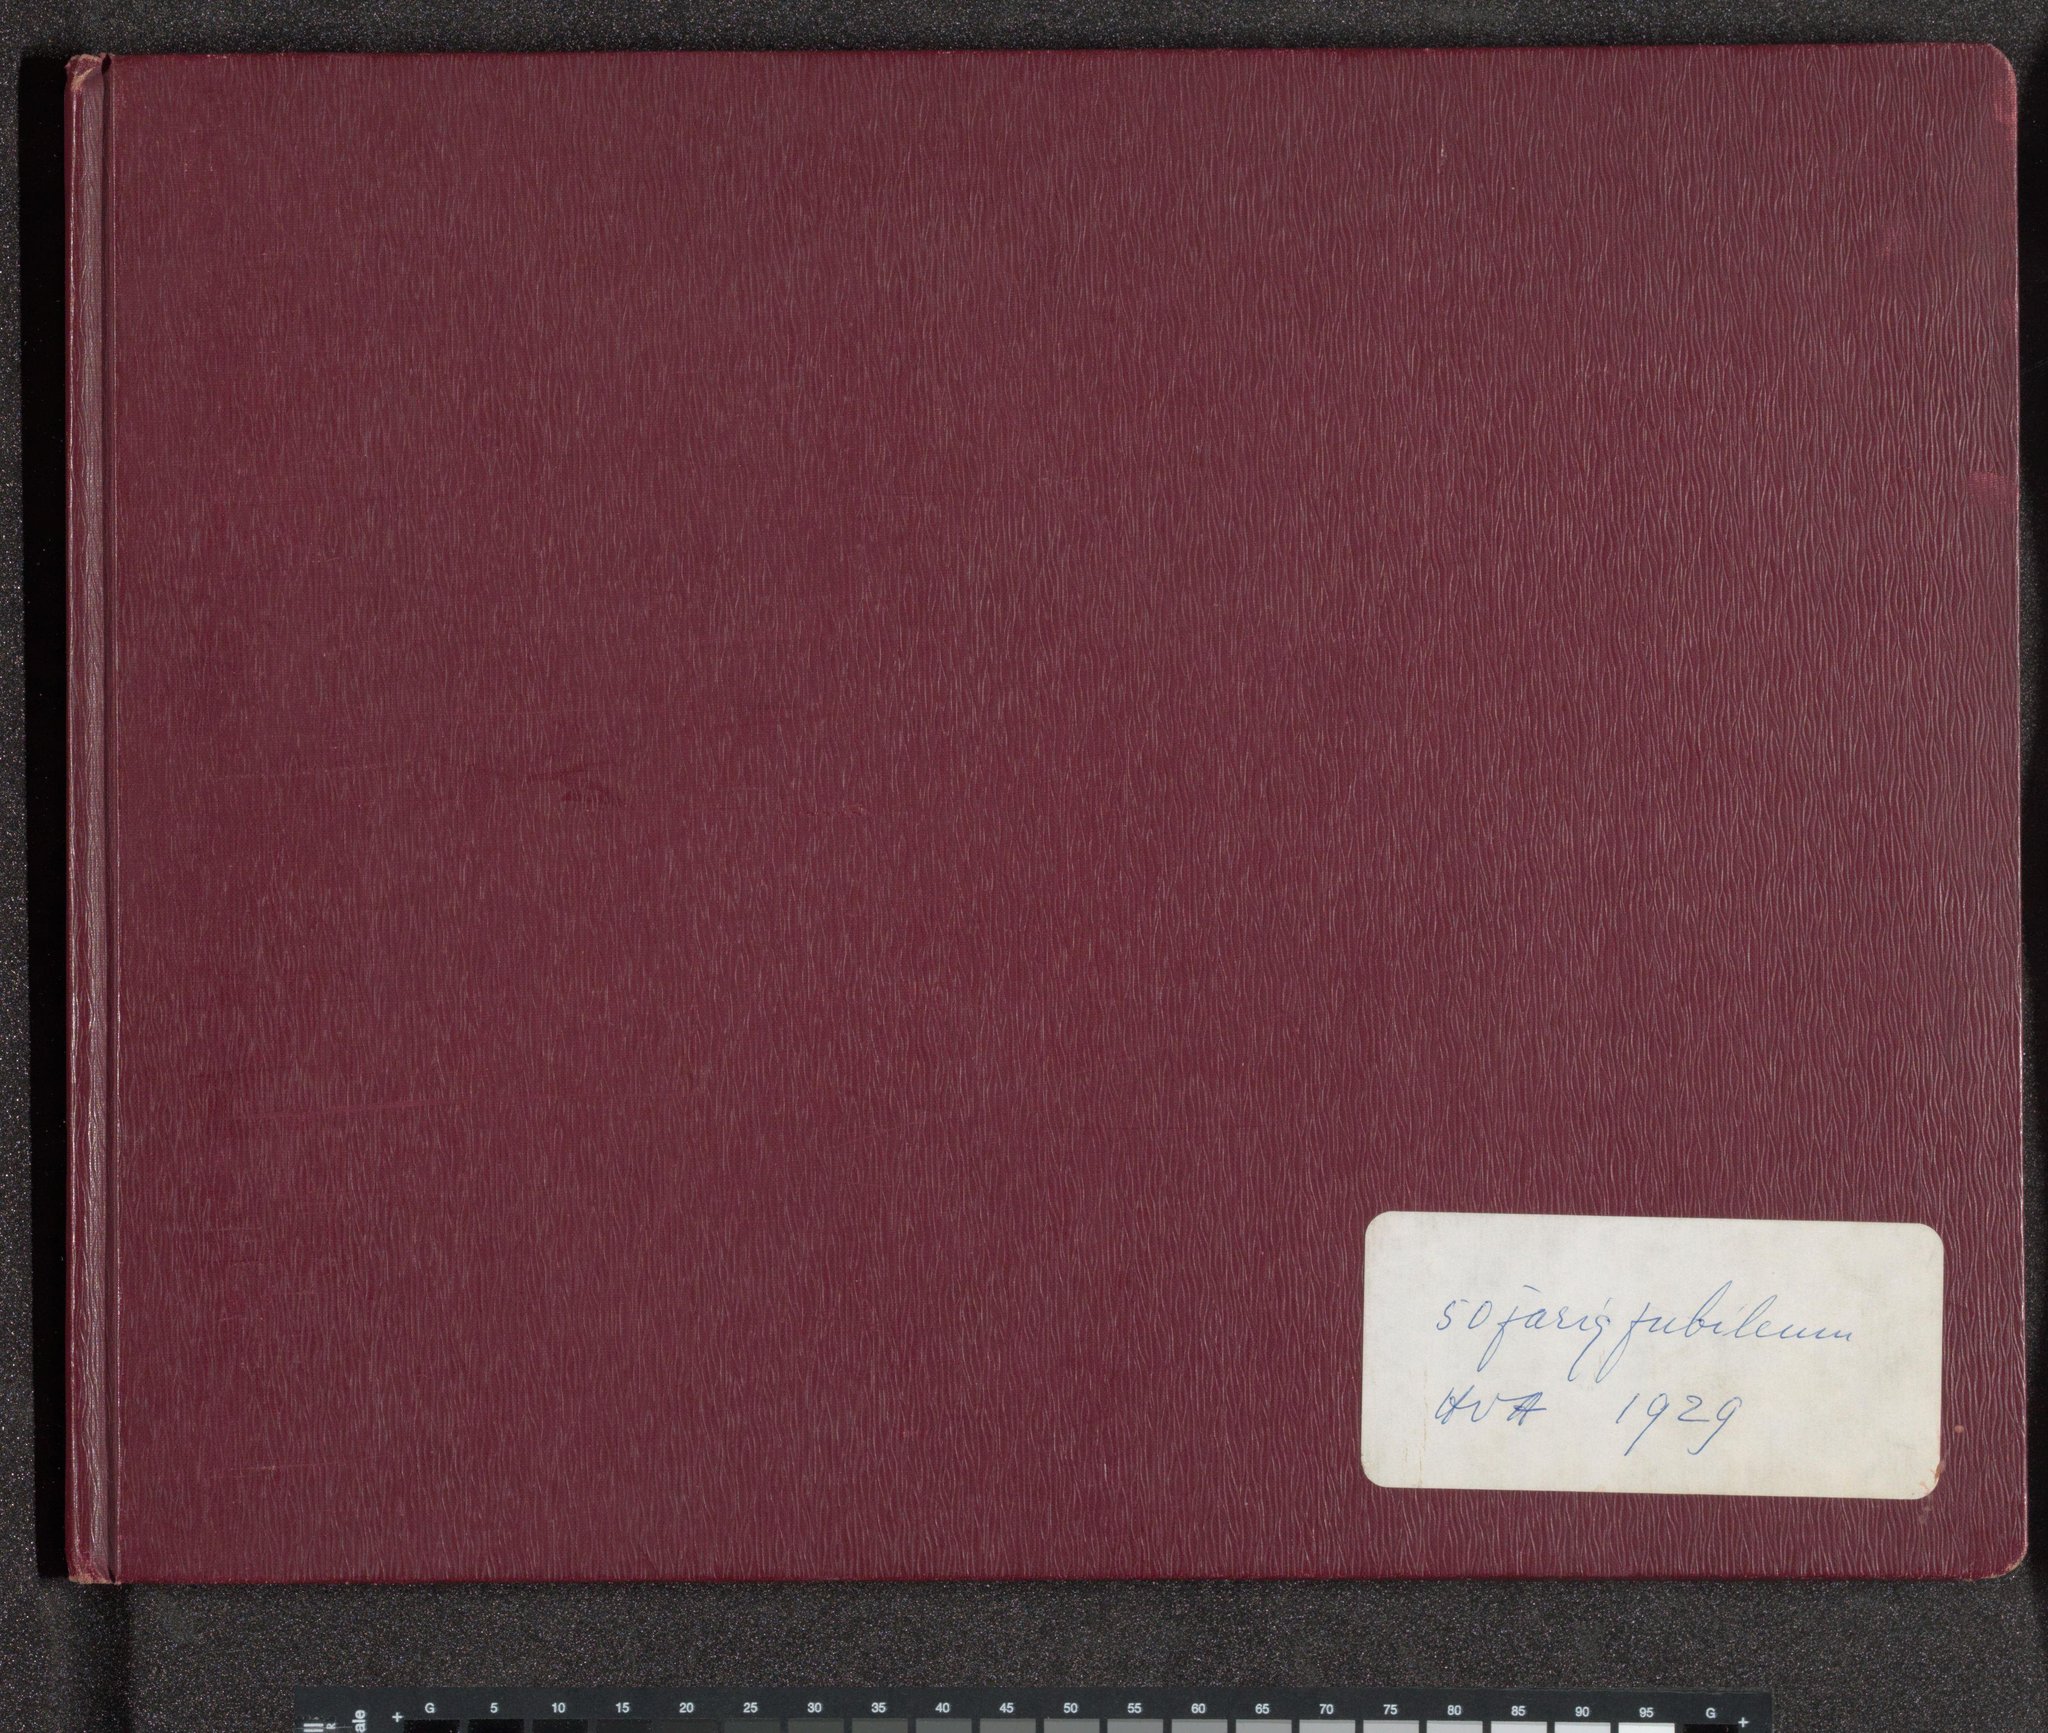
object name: photograph album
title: Fotoalbum ter gelegenheid van het 50-jarig jubileum van de Handelsvereniging Amsterdam (HVA)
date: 1929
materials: cardboard, linen, paper, photographic support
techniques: gelatin silver print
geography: amsterdam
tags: colonial system, trade-company, dutch east indies, the, amsterdam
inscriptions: label: ‘50 jarig jubileum HVA 1929’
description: Fotoalbum in rode linnen band met 6 bladen van bruin karton met ingeplakte groepsfoto's gemaakt tijdens het 50-jarig jubileum van de Handelsvereniging Amsterdam (HVA) zoals dat werd gevierd in het hoofdkantoor te Amsterdam in 1929.